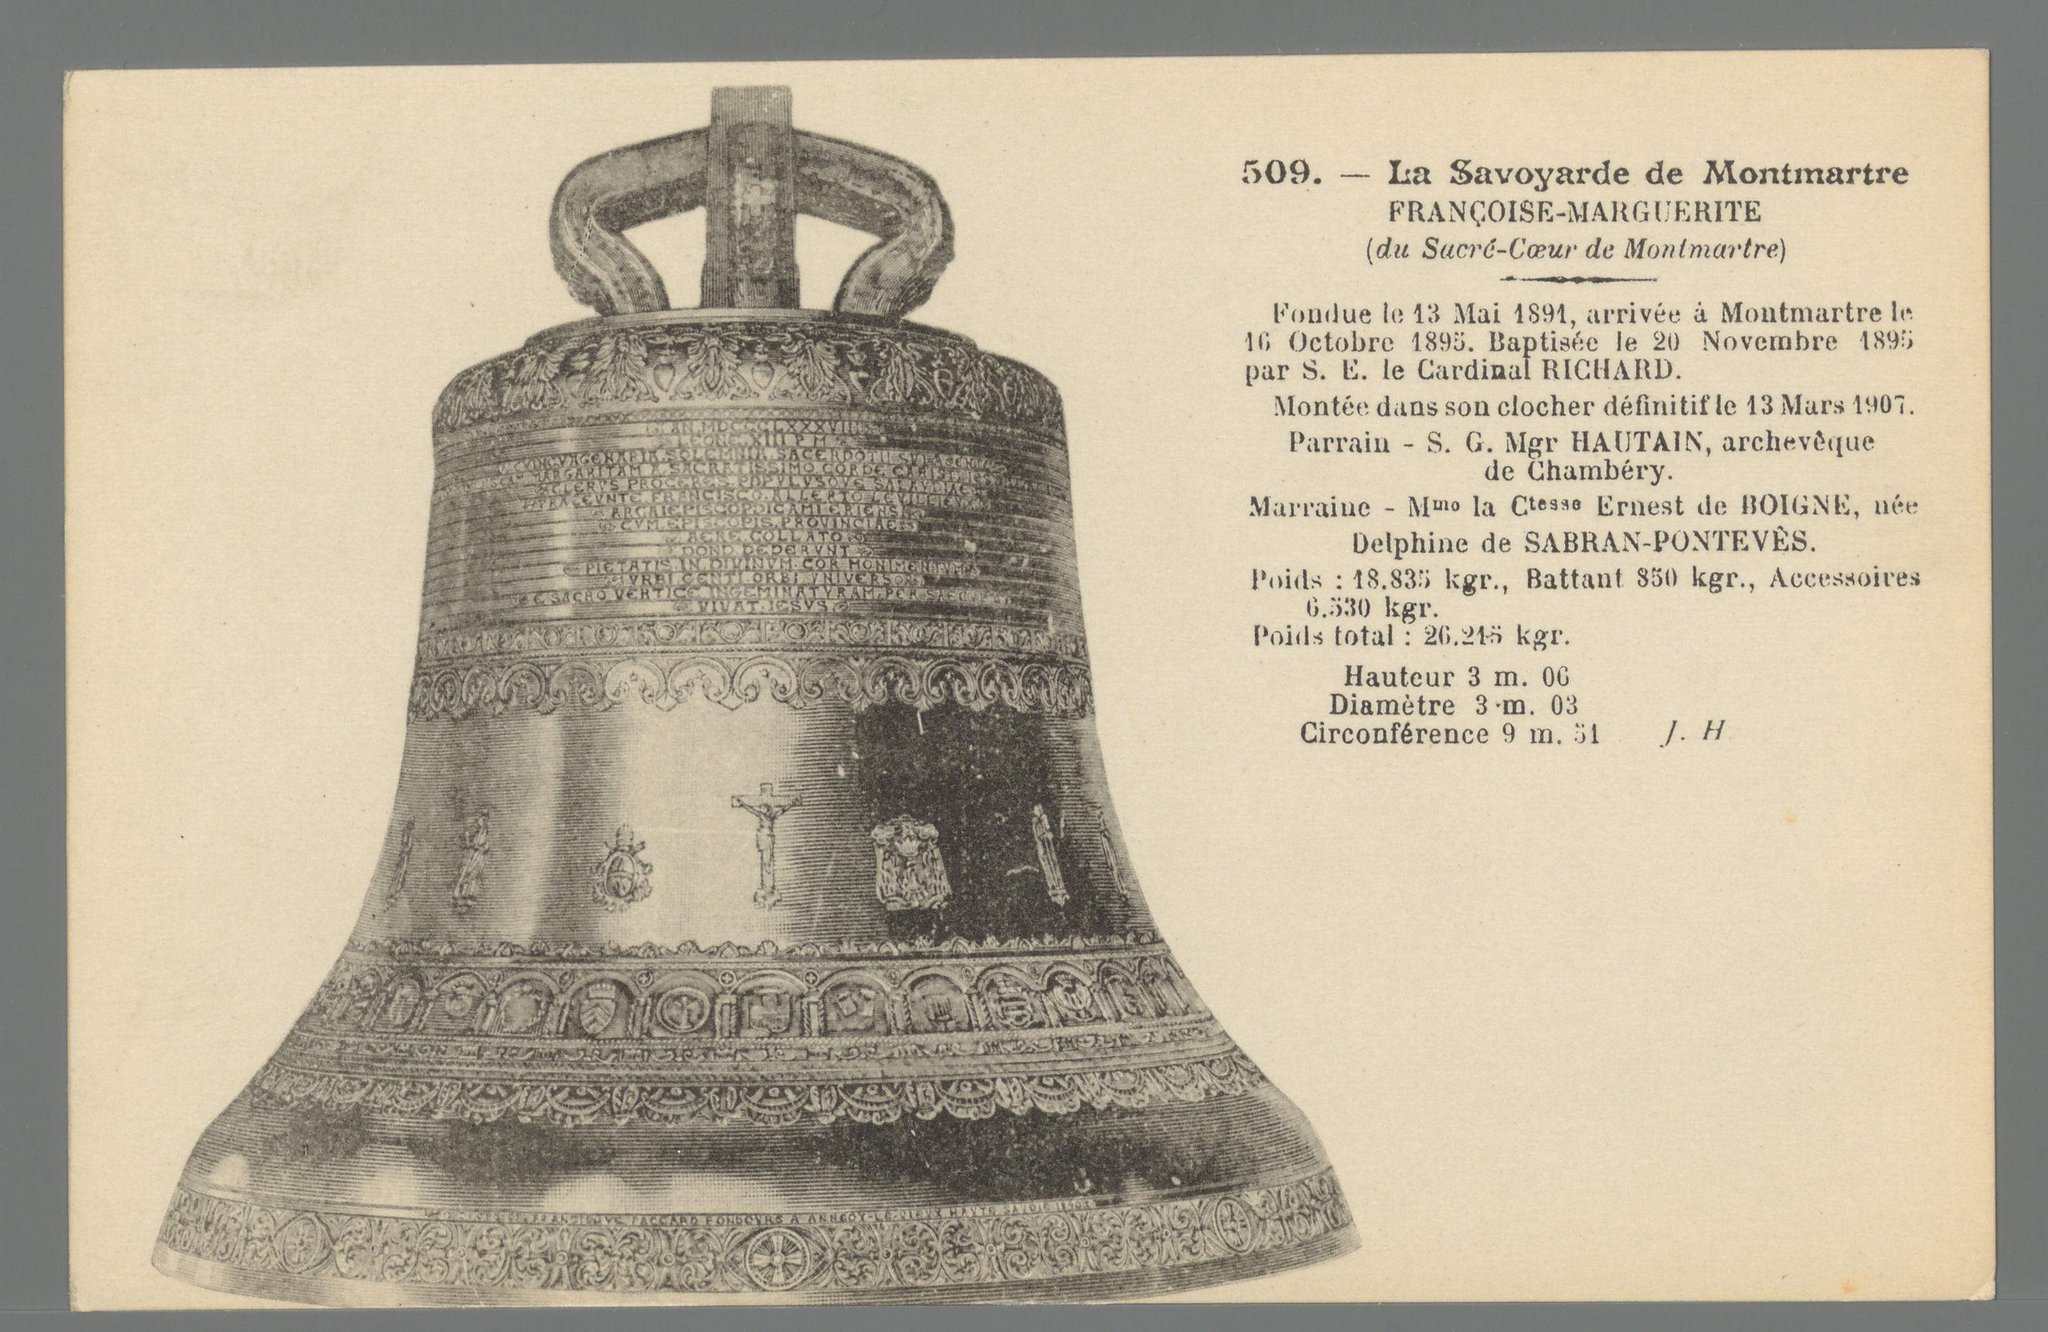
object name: photomechanical print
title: La Savoyarde de Montmartre, Françoise-Marguerite (du Sacré-Coeur de Montmartre)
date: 1903-1920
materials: cardboard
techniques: photograph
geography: paris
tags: church bell